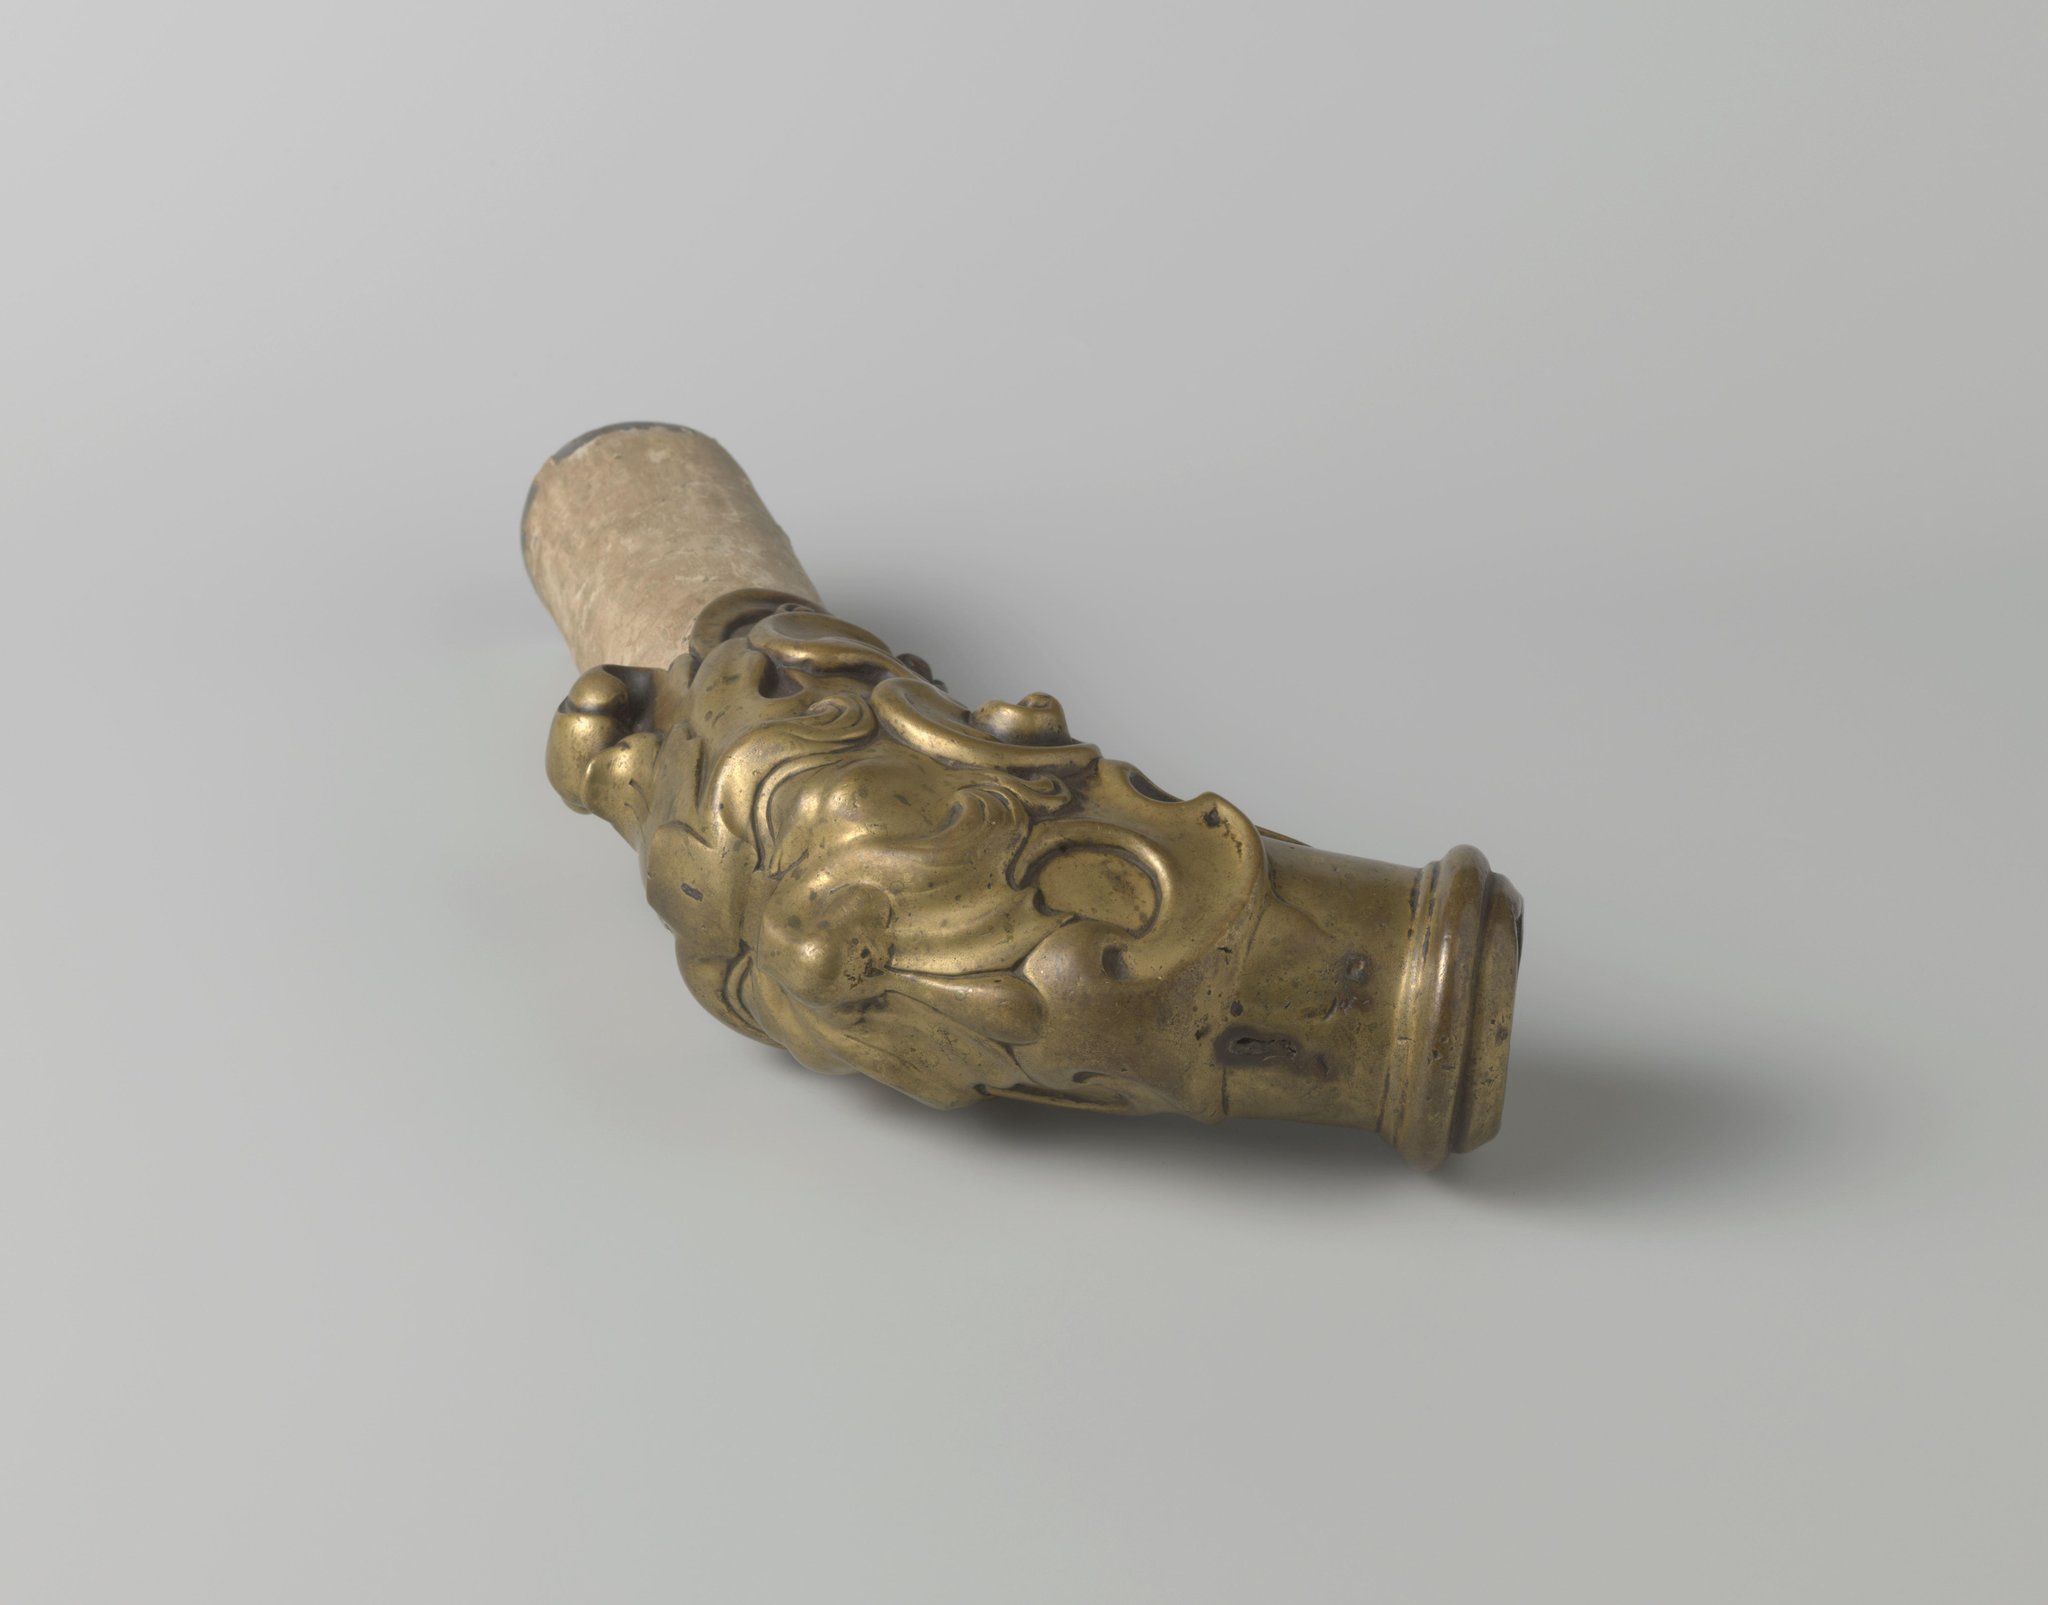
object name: waterpomp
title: Spuier van een waterpomp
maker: Anonymous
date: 1625-1675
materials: brass, lead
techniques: casting, metalworking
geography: northern netherlands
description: Het voorwerp bestaat uit een loden buis met een geelkoperen gegoten en bijgeciseleerd mondstuk. Dit heeft de vorm van een masker met ogen, neus en drakenvleugels als oren, met een geprofileerde rand om de opening.